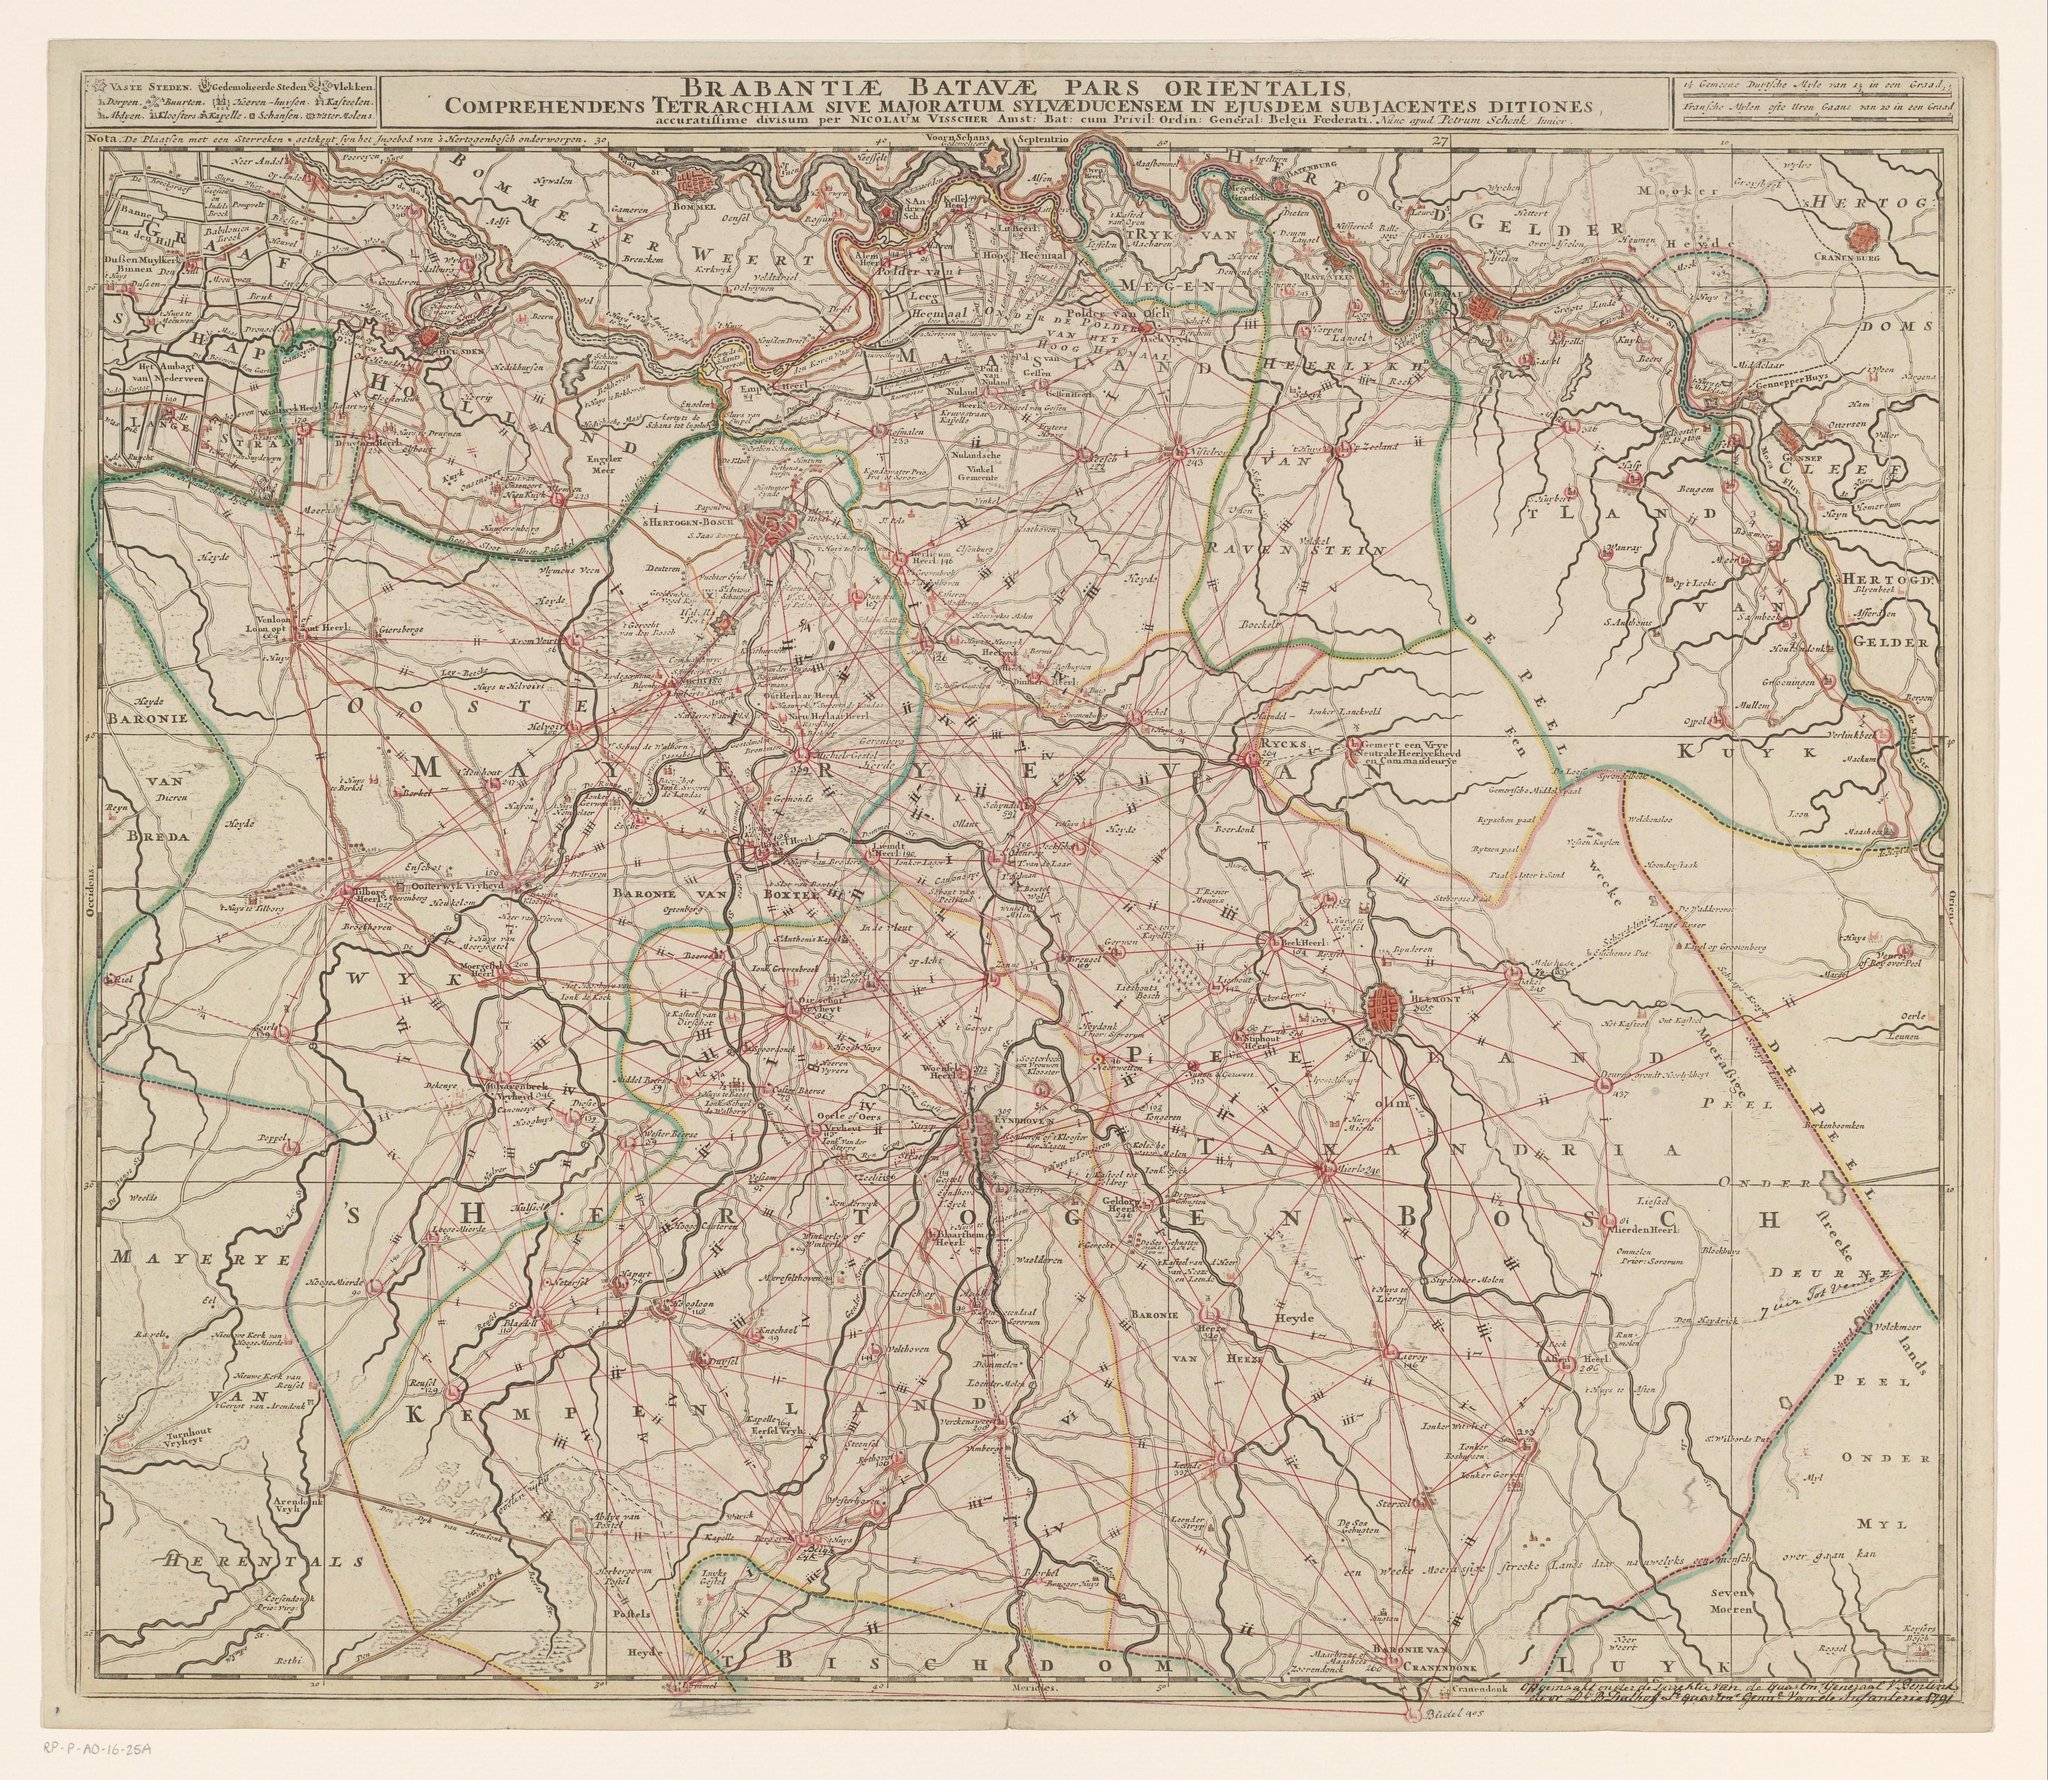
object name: print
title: Brabantiae Batavae pars orientalis comprehendens tetrarchiam sive majoratum Sylvaeducensem in ejusdem subjacentes ditiones (...)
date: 1677-1720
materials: ink, paper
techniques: brush, engraving, etching, pen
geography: amsterdam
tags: maps of separate countries or regions, brabant, den bosch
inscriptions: inscription: ‘Opgemaakt onder de Direktie van de quartmr Generaal V. Bentink door D.G.B. Dalhoff St quartmr Genn van de Infanterie 1791.’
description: Kaart van het oostelijk deel van Brabant. Titel en privilege in een strook boven de kaart. Legenda linksboven. Schaalstokken rechtsboven: 1 1/2 Gemeene Duytsche Myle van 15 in een Graad / Fransche Mylen ofte Uren Gaens van 20 in een Graad. De kaart is voorzien van een coördinaten-net en een gradenverdeling langs de randen.